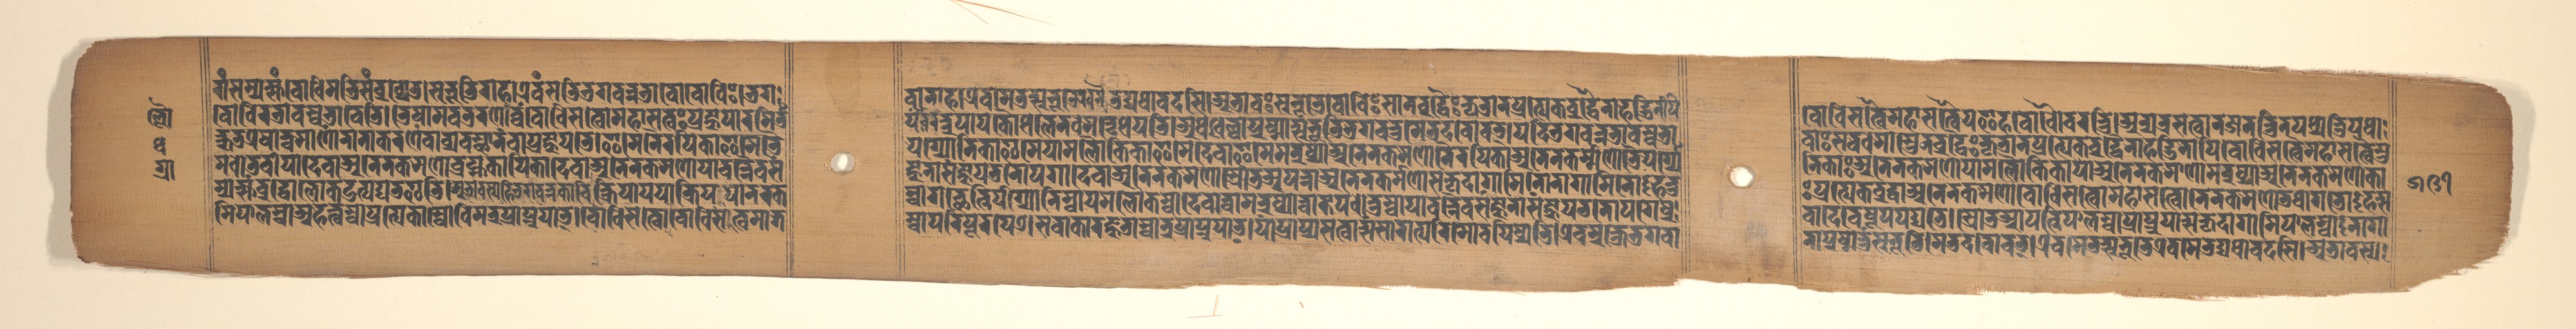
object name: folio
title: Folio from a Buddhist Manuscript of Pancavimsatisahasrika Prajnaparamita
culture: indian, bengal or bangladesh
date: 1090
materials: leaf, watercolor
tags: buddhism